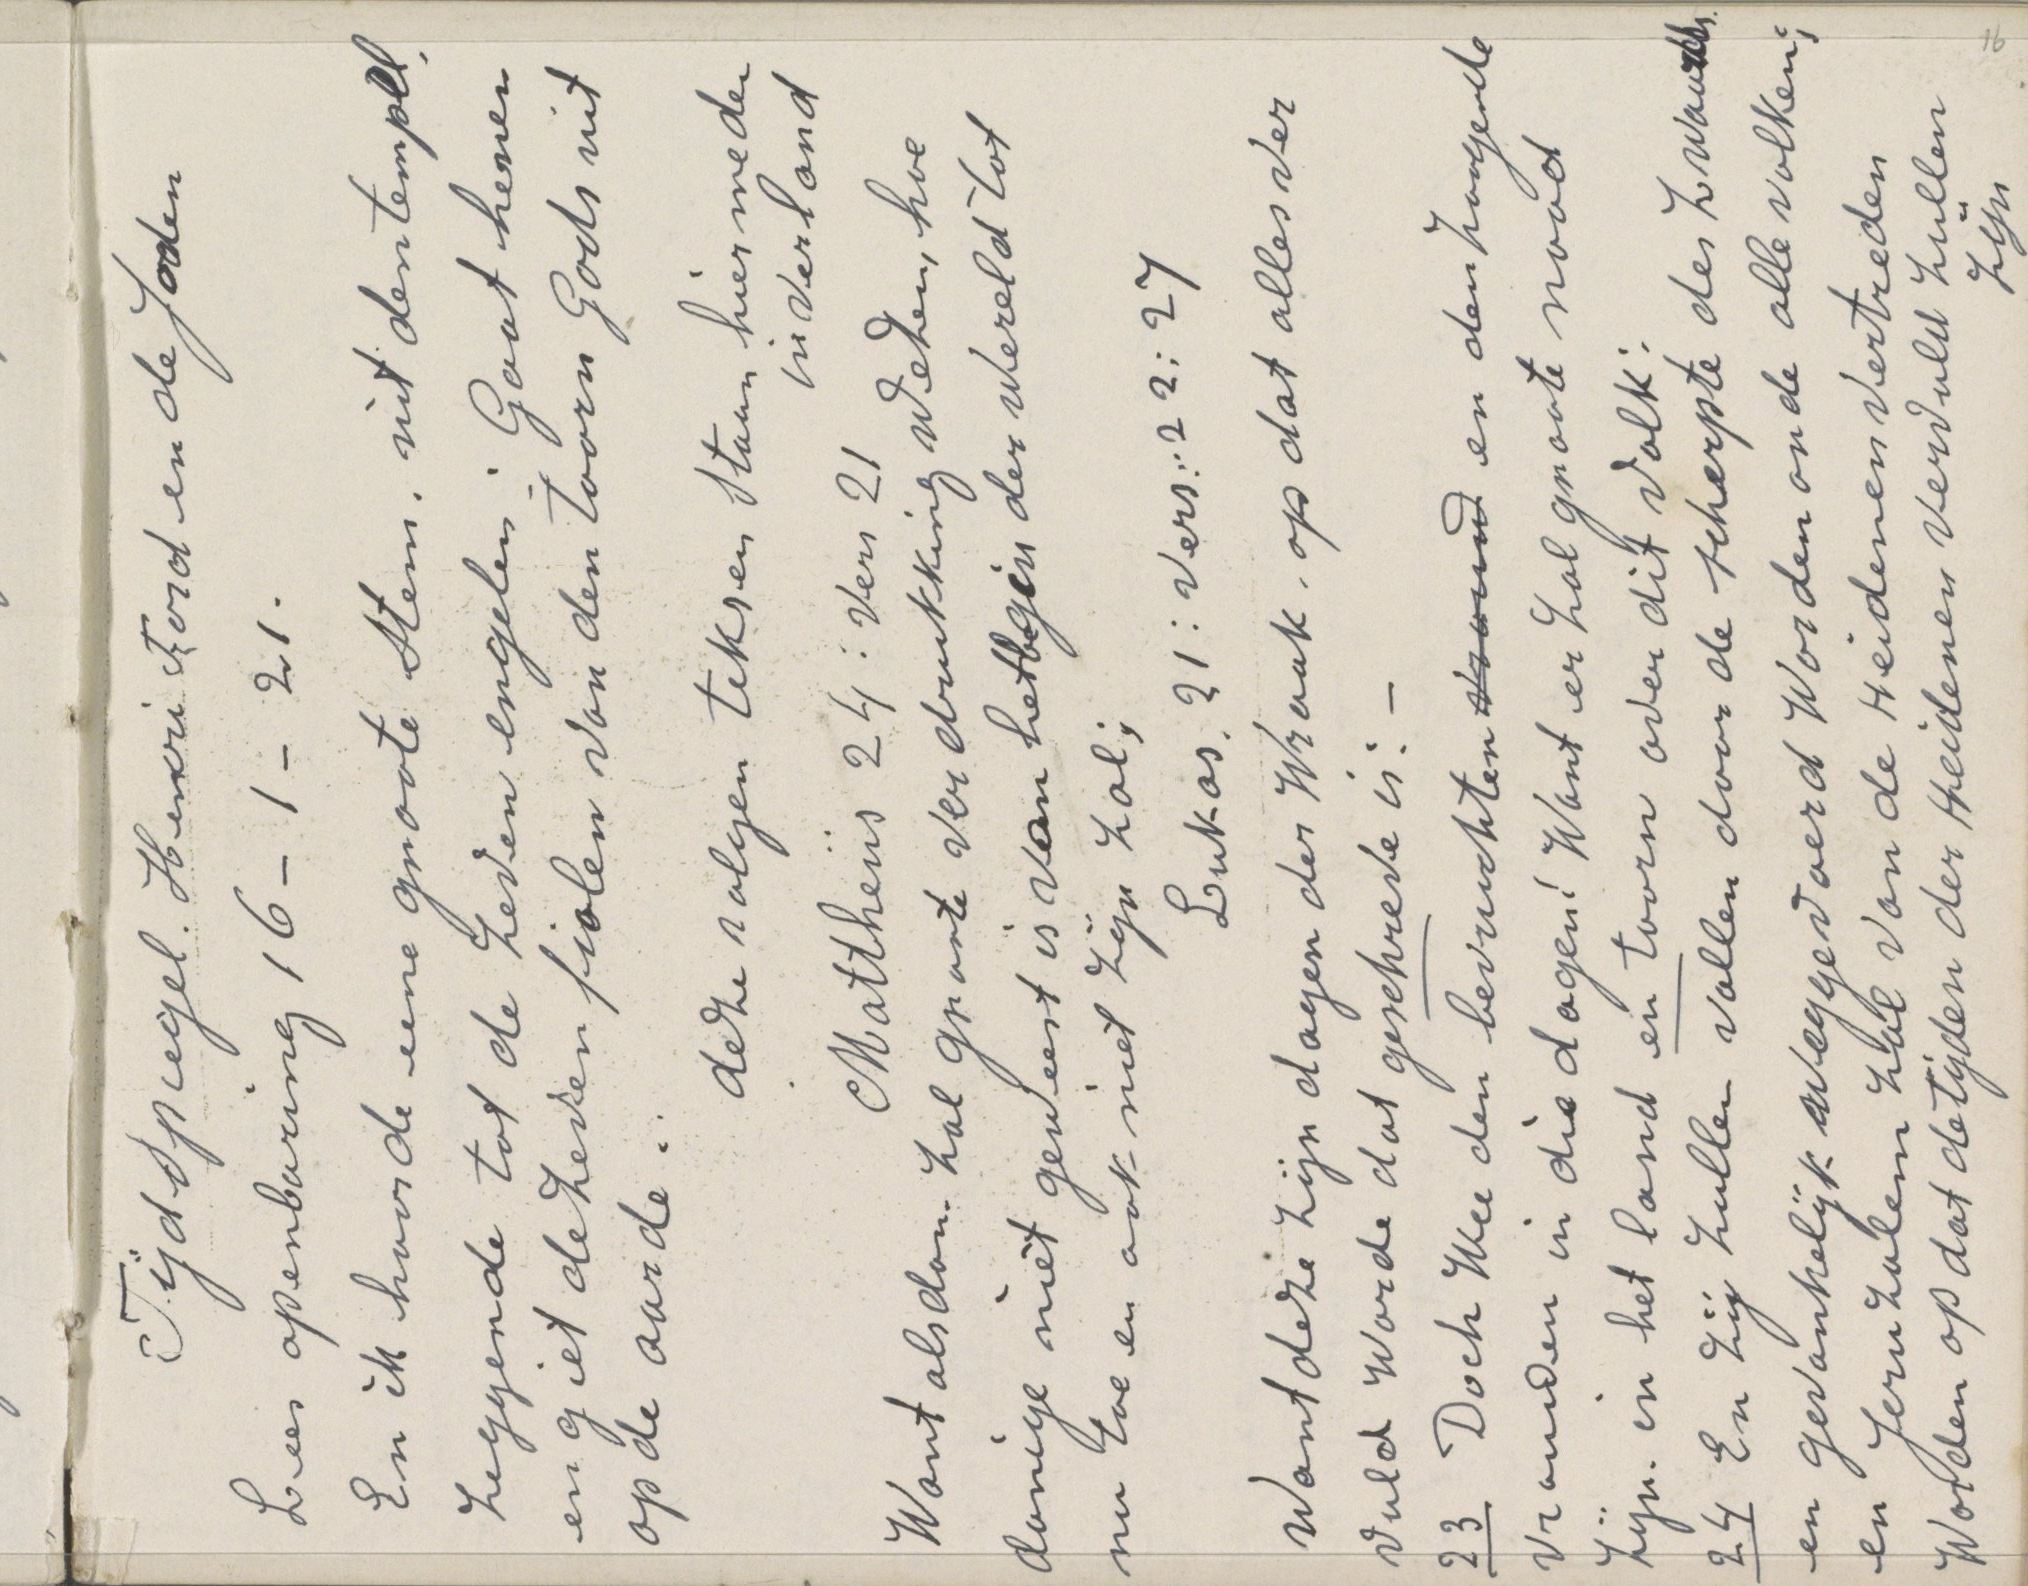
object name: sketchbook leaf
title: Bijbelverzen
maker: marie jordan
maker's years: 1866-1948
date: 1906-1948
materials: ink, paper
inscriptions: annotation: ‘[...]’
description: Pagina 16 uit een schetsboek met 31 bladen.